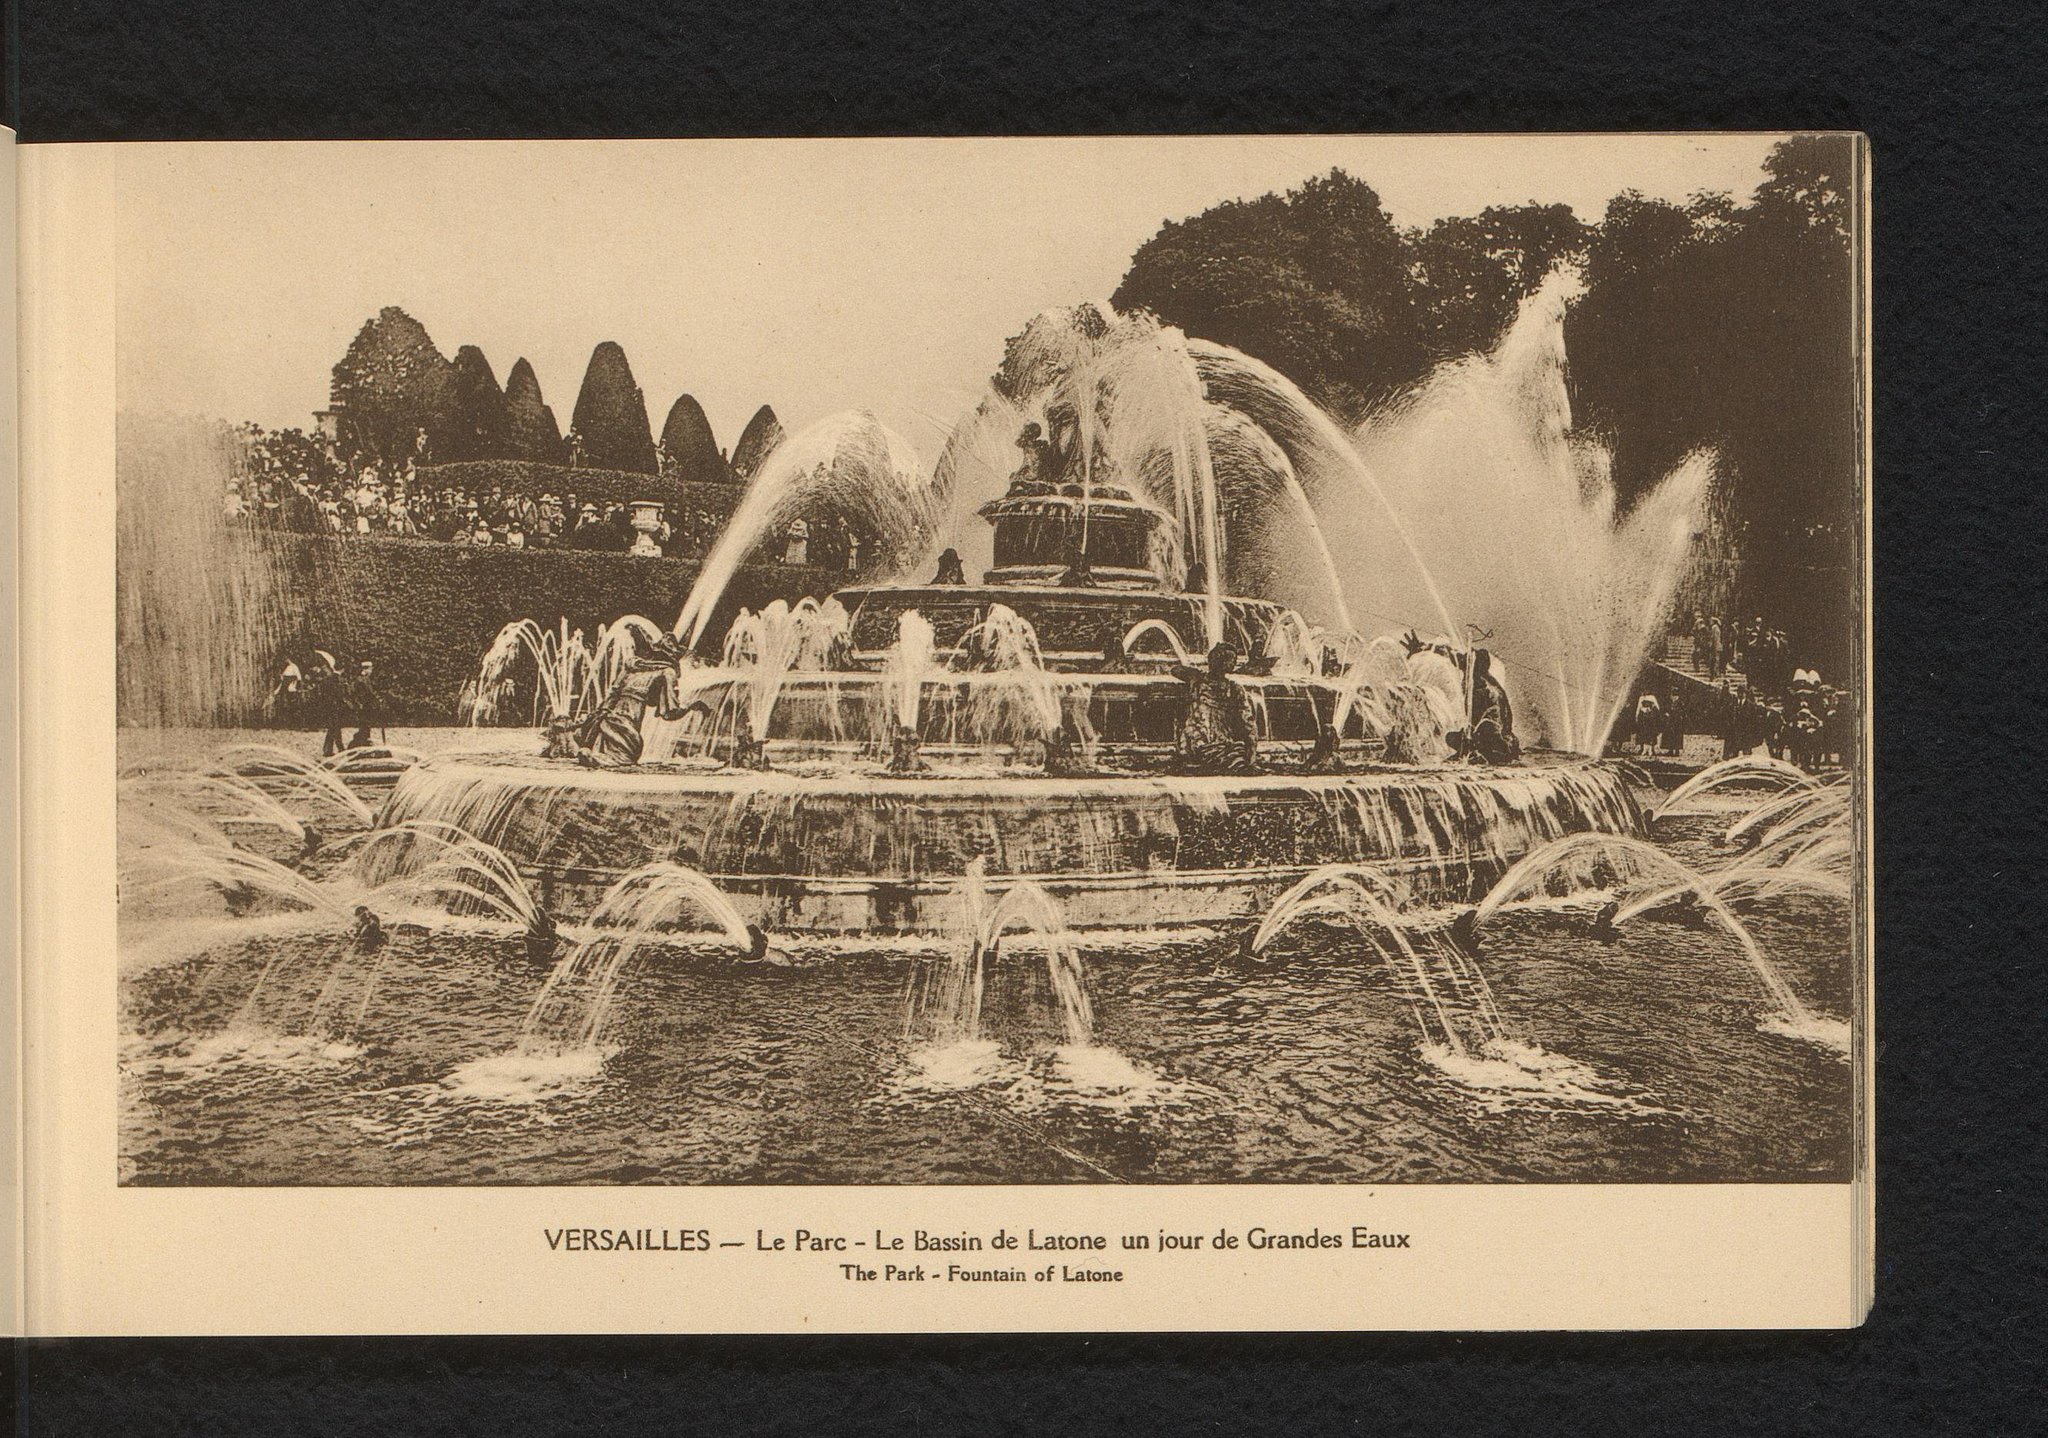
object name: photomechanical print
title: Versailles. Le Parc. Le Bassin de Latone un jour de Grandes Eaux / The Park. Fountain of Latone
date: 1919-1930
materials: cardboard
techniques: photograph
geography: versailles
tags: garden fountain, french or architectonic garden; formal garden